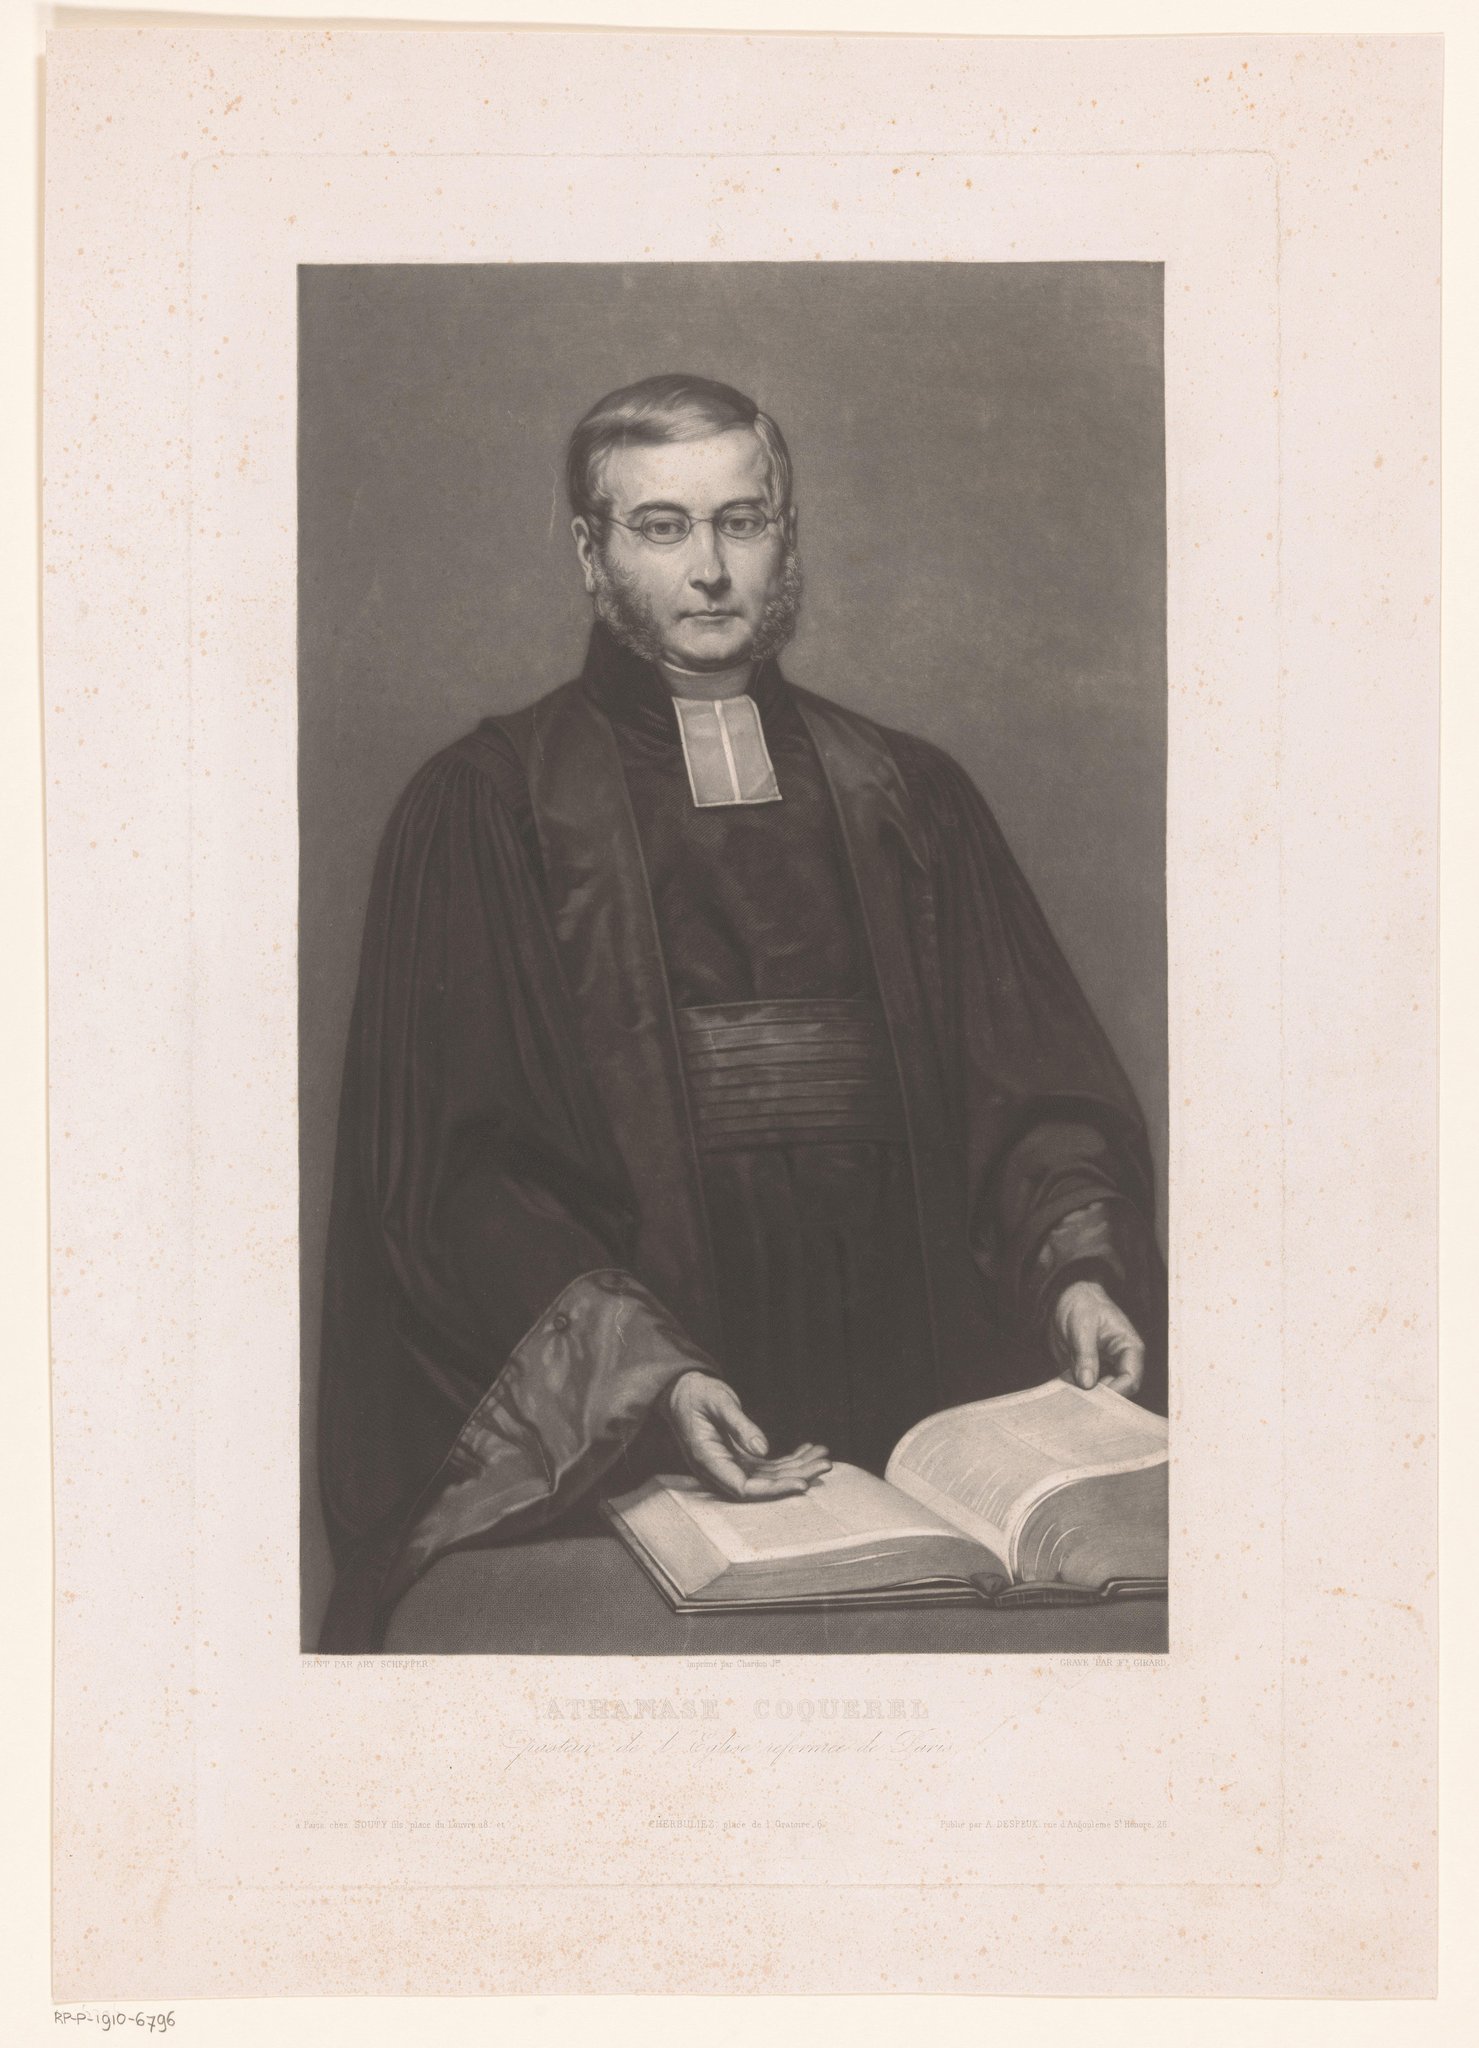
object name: print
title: Portret van Athanase Laurent Charles Coquerel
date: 1797-1870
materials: paper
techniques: etching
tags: theologian, historical persons, functionaries and dignitaries ~ protestant churches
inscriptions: collector's mark: Lugt 2228, check stamp